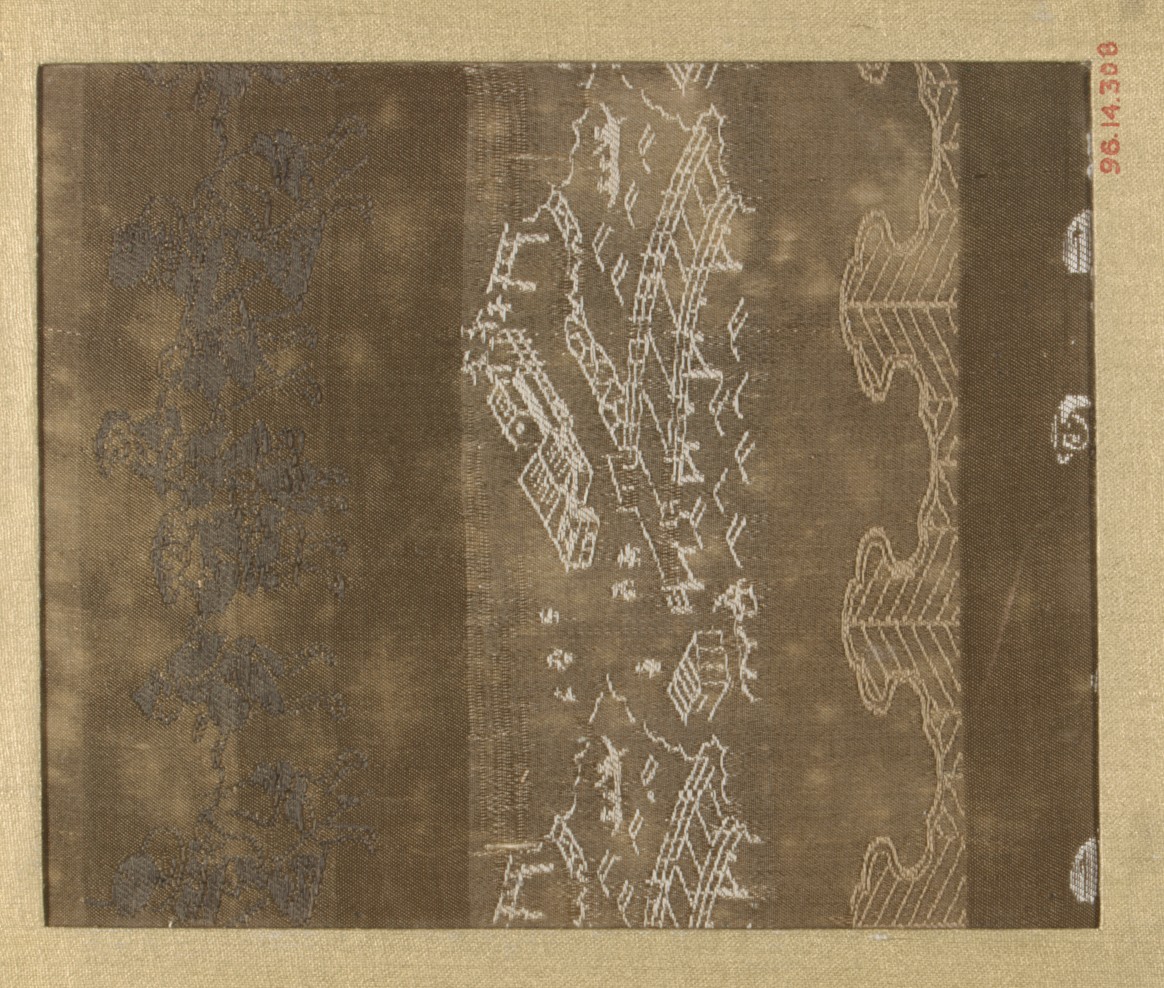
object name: piece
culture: japanese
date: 1701-1900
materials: silk